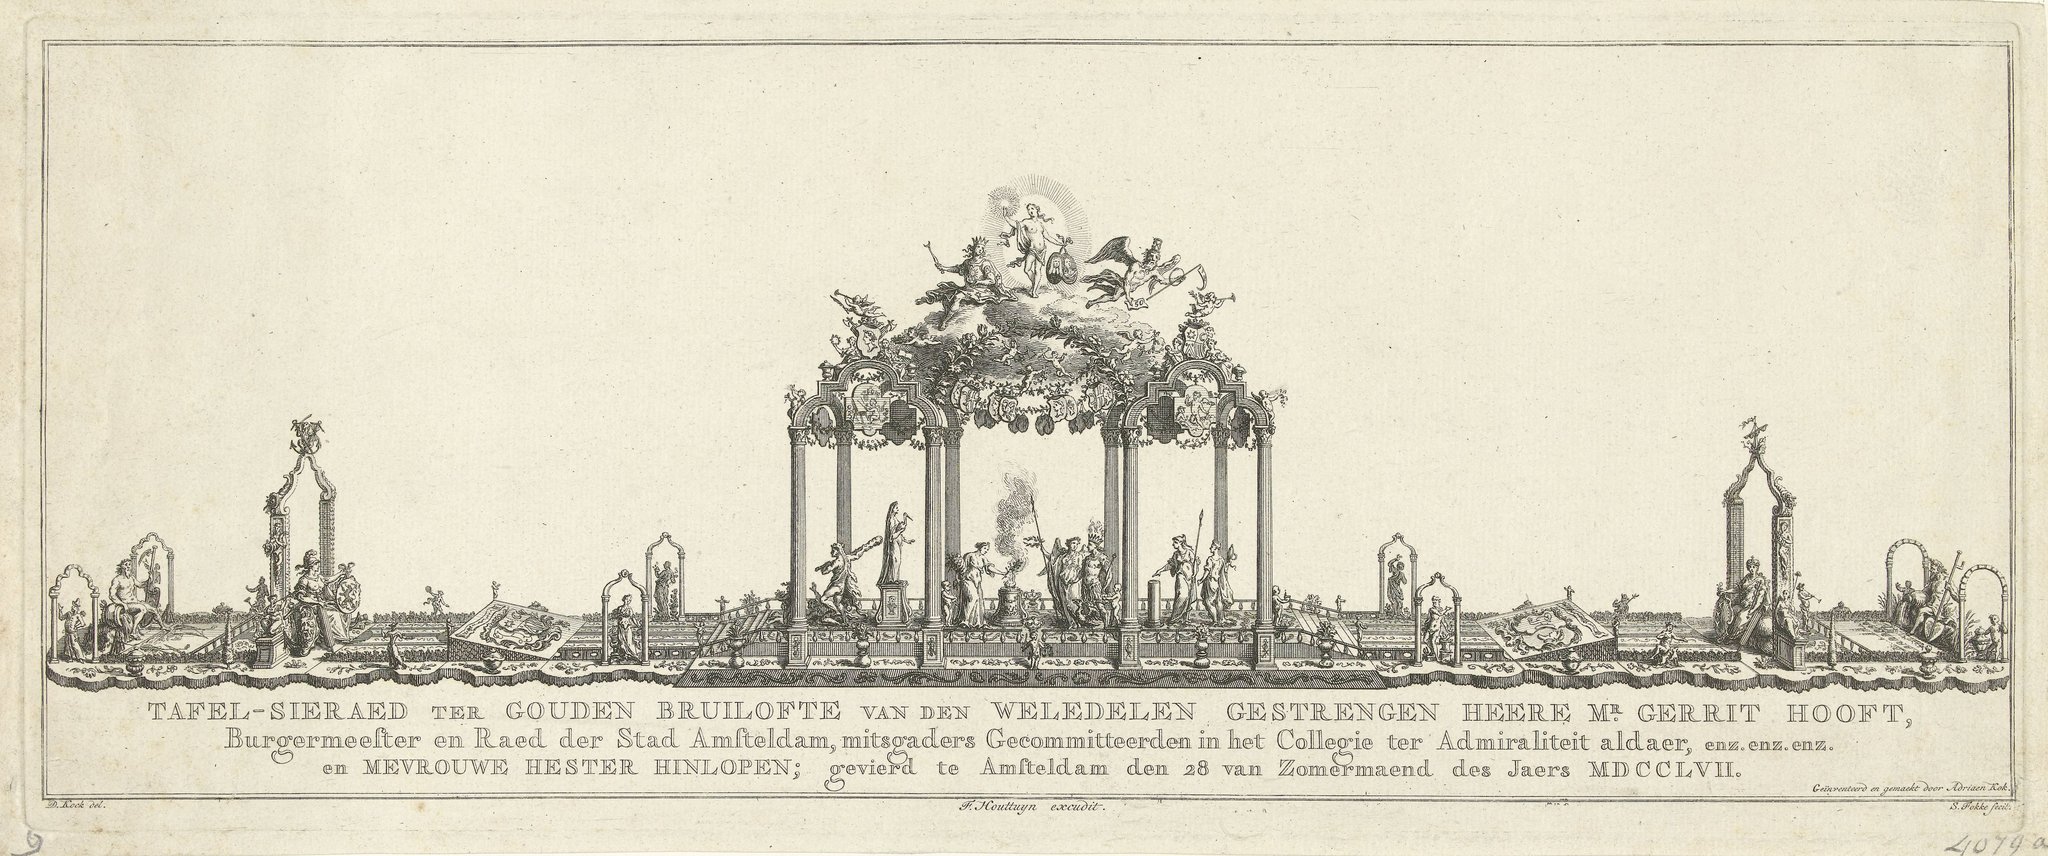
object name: print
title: Tafel-Sieraed ter Gouden Bruilofte van den Weledelen Gestrengen Heere Mr. Gerrit Hooft, Burgermeester en Raed der Stad Amsteldam (...) en Mevrouwe Hester Hinlopen; gevierd te Amsteldam den 28 van Zomermaend des Jaers MDCCLVII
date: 1757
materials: paper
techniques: etching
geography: northern netherlands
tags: fancy-cakes, fancy-pastries, golden anniversary, amsterdam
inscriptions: collector's mark: Lugt 2228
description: Tafelversiering voor het feestmaal ter gelegenheid van de gouden bruiloft van burgermeester van Amsterdam Gerrit Hooft en zijn vrouw Hester Hinloopen, op 28 juni 1757. Decoratie of sieraad in gebak in de vorm van een tuin met in het midden een tempel, priëlen en allegorische figuren, gemaakt door de Amsterdamse suikerbakker Adriaen Kok.